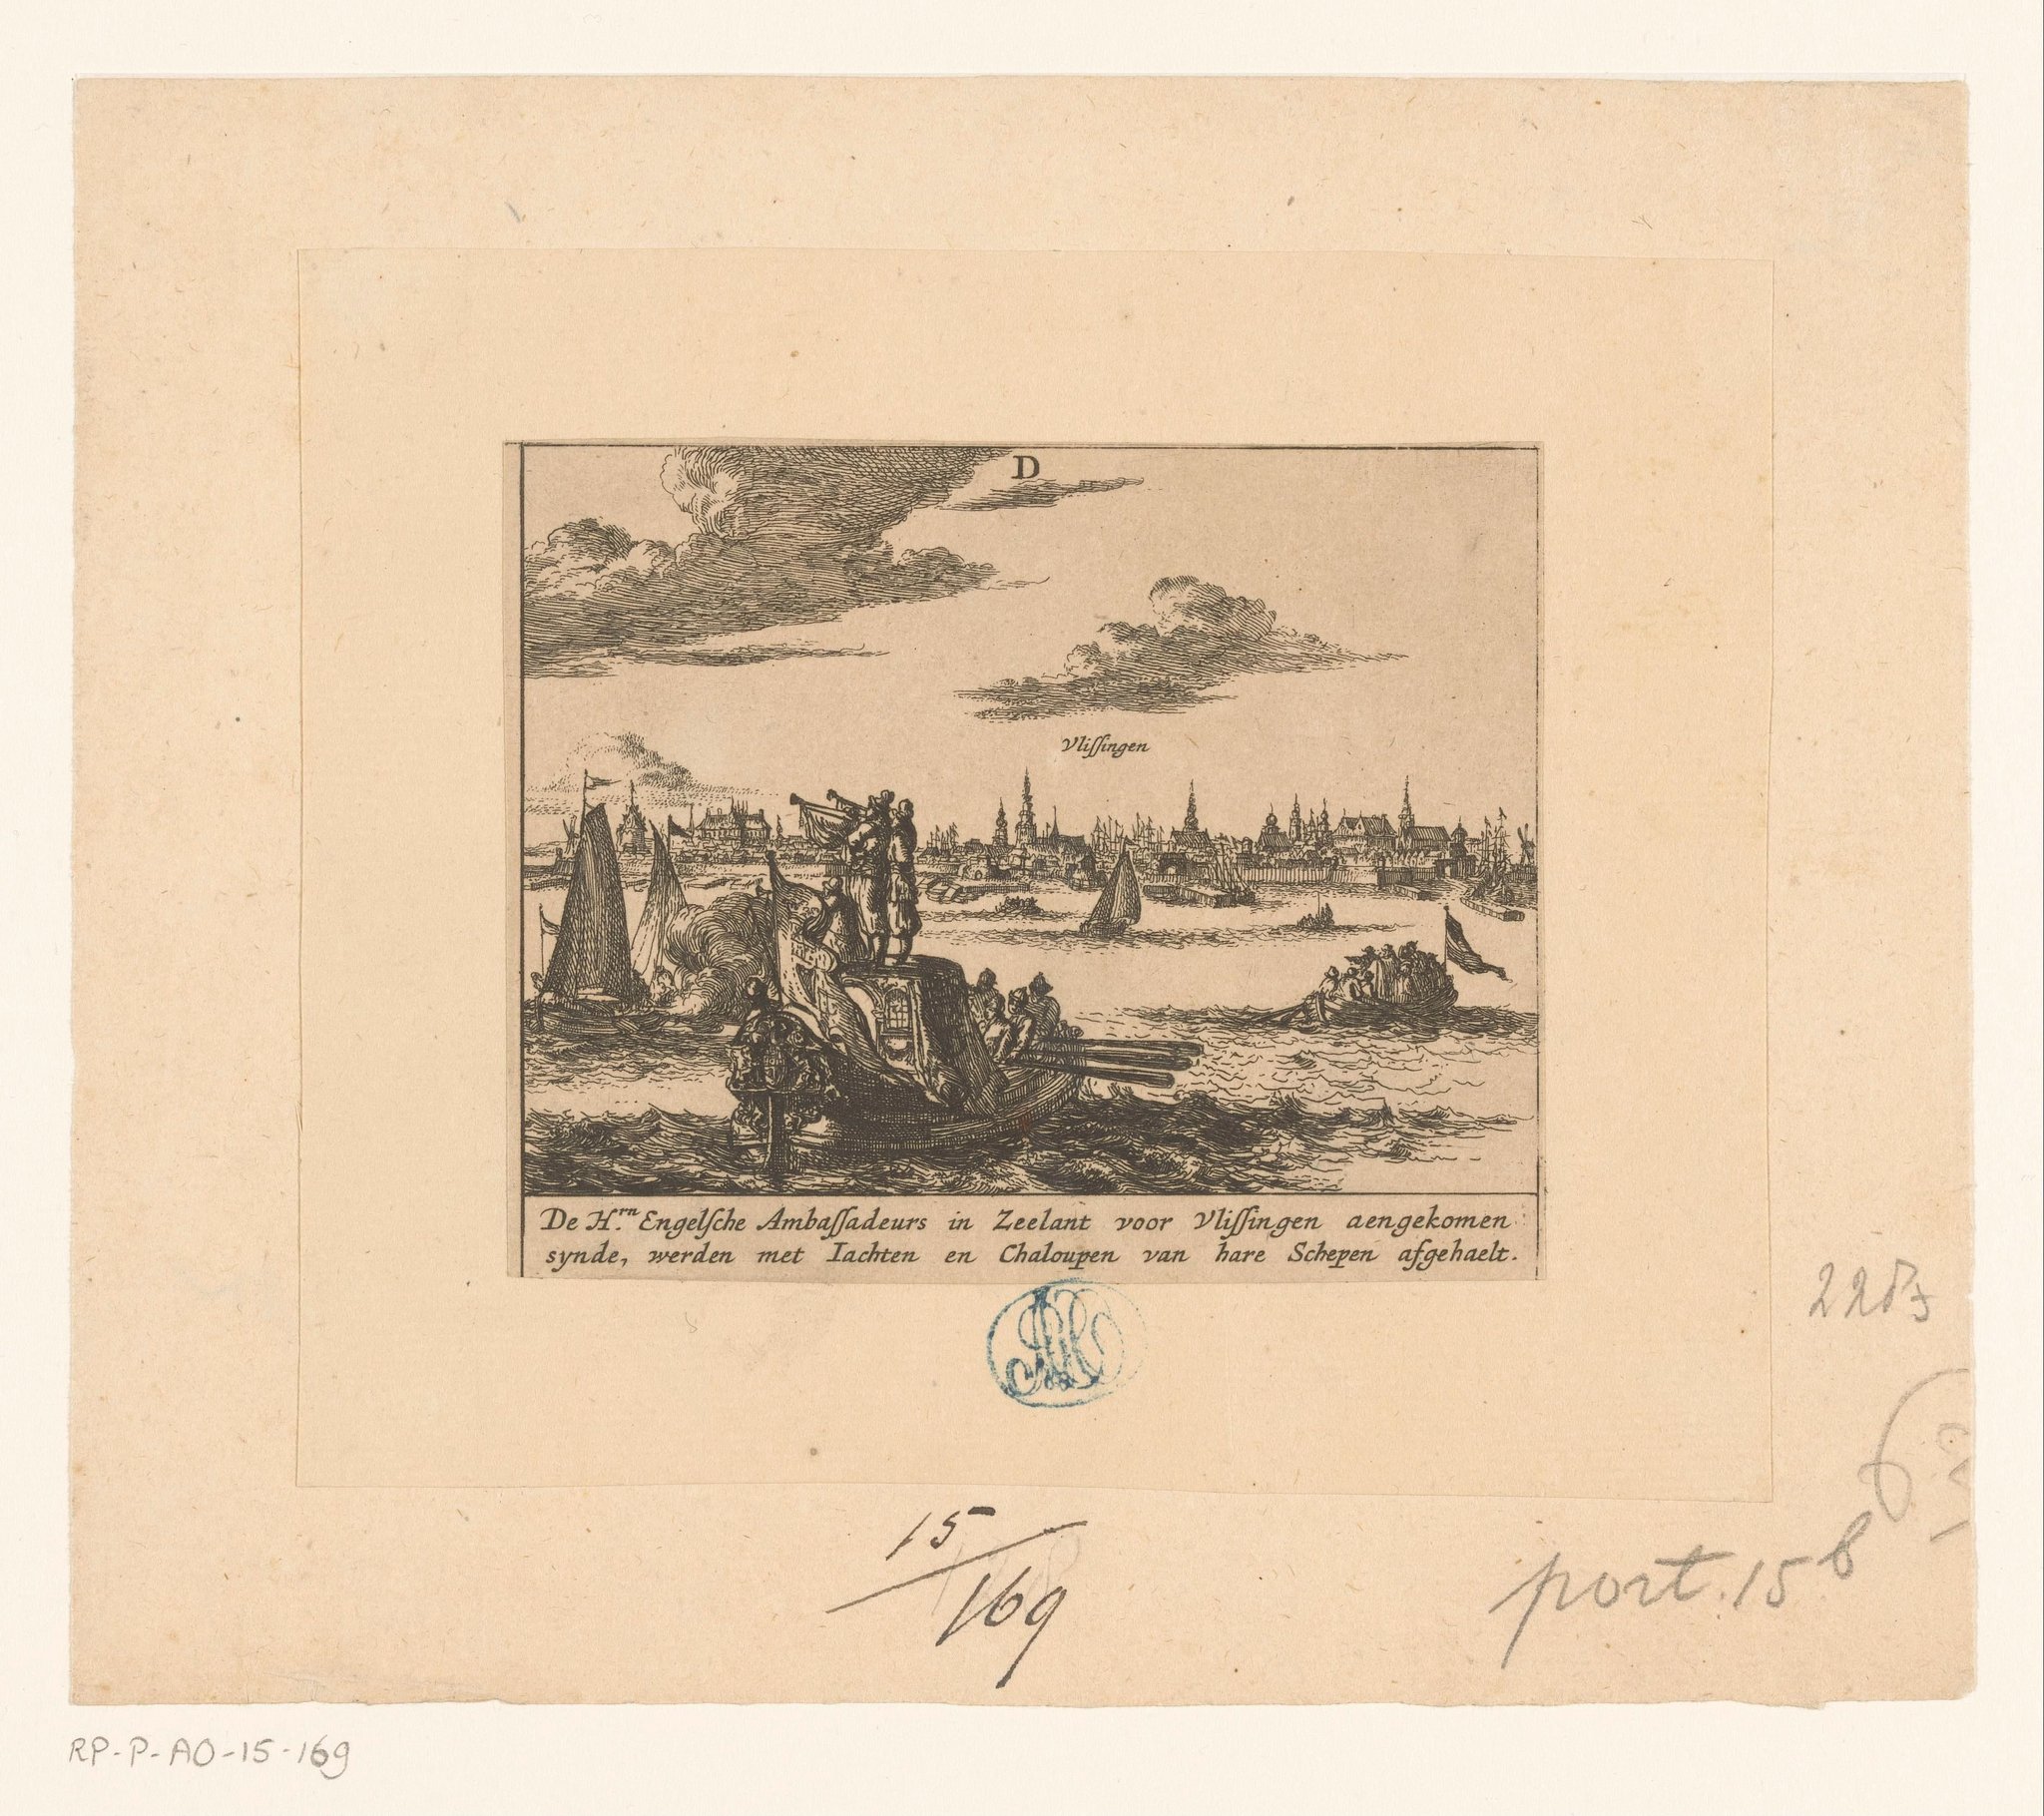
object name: print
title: The Treaty of Peace concluded, at Breda on the 31.th July, by the Authorised of ther Ma.ties of Great Brittanie, France, Denmarck, and the high and mighty Lords, the States Generall, of the United Netherlands, and ratified in the Chamber of conferrance, on the 24.th August 1667. S.N.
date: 1667-1765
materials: paper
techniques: engraving, etching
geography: northern netherlands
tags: sailing-ship, sailing-boat, rowing-boat, canoe, etc., signing of peace treaty, concluding the peace, reception ~ ambassador, flushing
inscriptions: collector's mark: Lugt 195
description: Afgesneden van een grote prent over de Vrede van Breda (zie RP-P-OB-79.261 en RP-P-OB-79.262). Van deze prent zijn twee staten bekend waarvan de een vermoedelijk naar aanleiding van de vrede werd uitgegeven en de ander later, door Joachim of Josua Ottens. Het is niet na te gaan van welke van de twee staten dit deel is afgesneden.